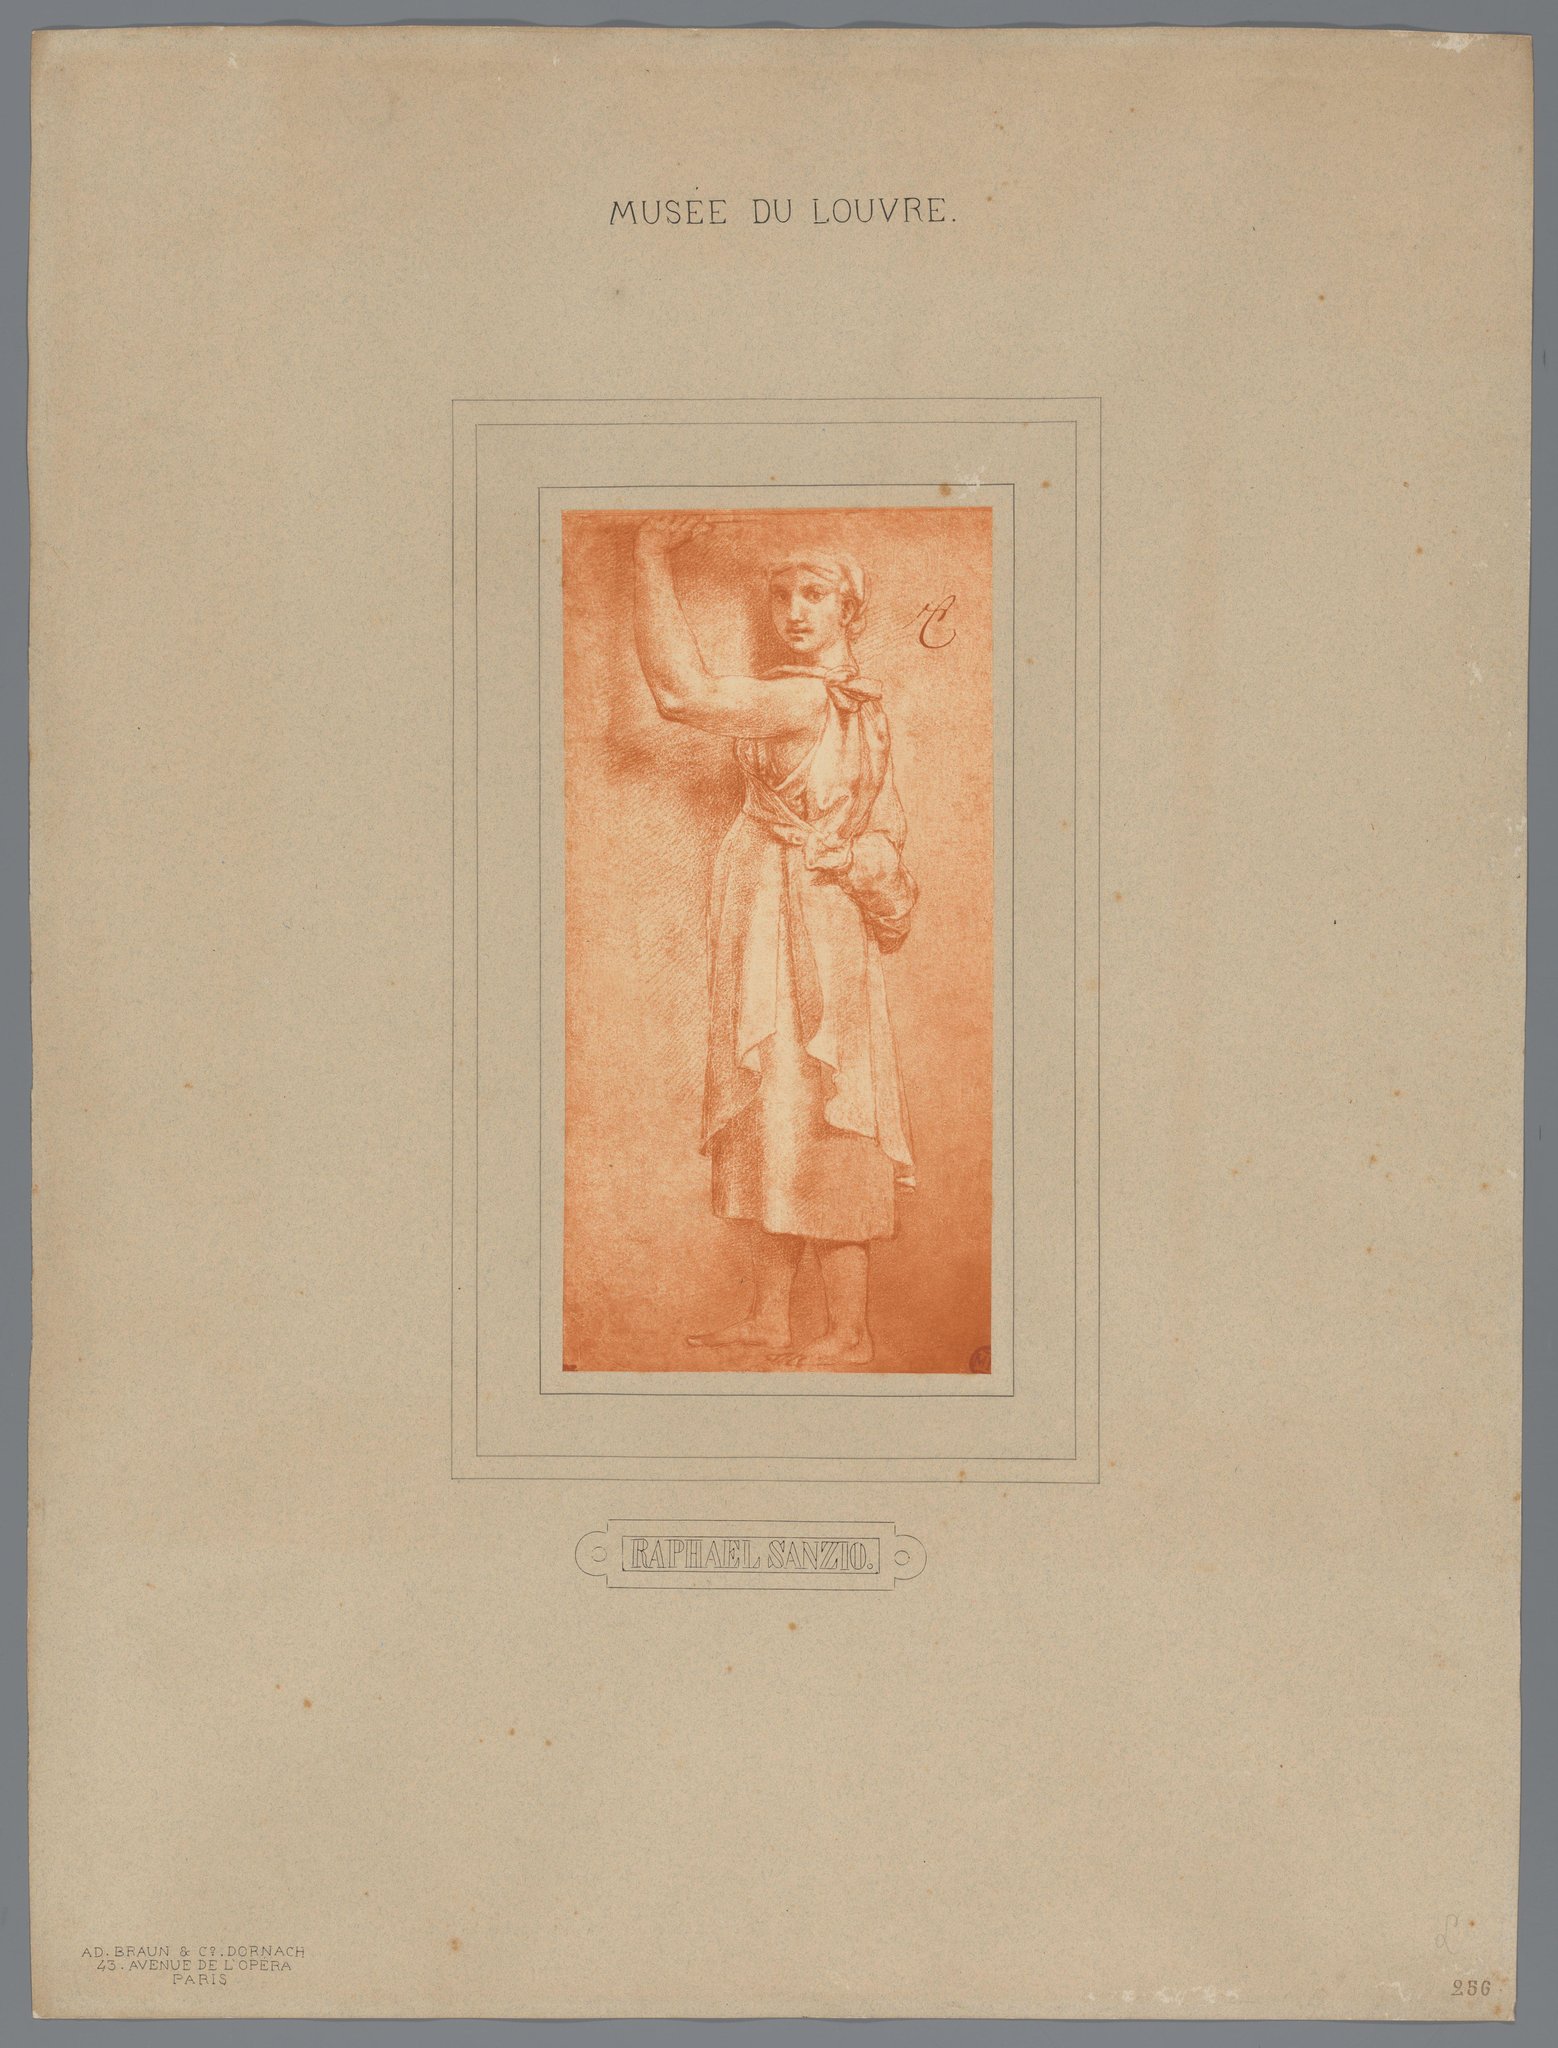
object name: photograph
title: Fotoreproductie van een tekening van Rafaël (figuurstudie) (coll. Louvre)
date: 1880-1900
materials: cardboard, paper, photographic support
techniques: carbon print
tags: musée du louvre